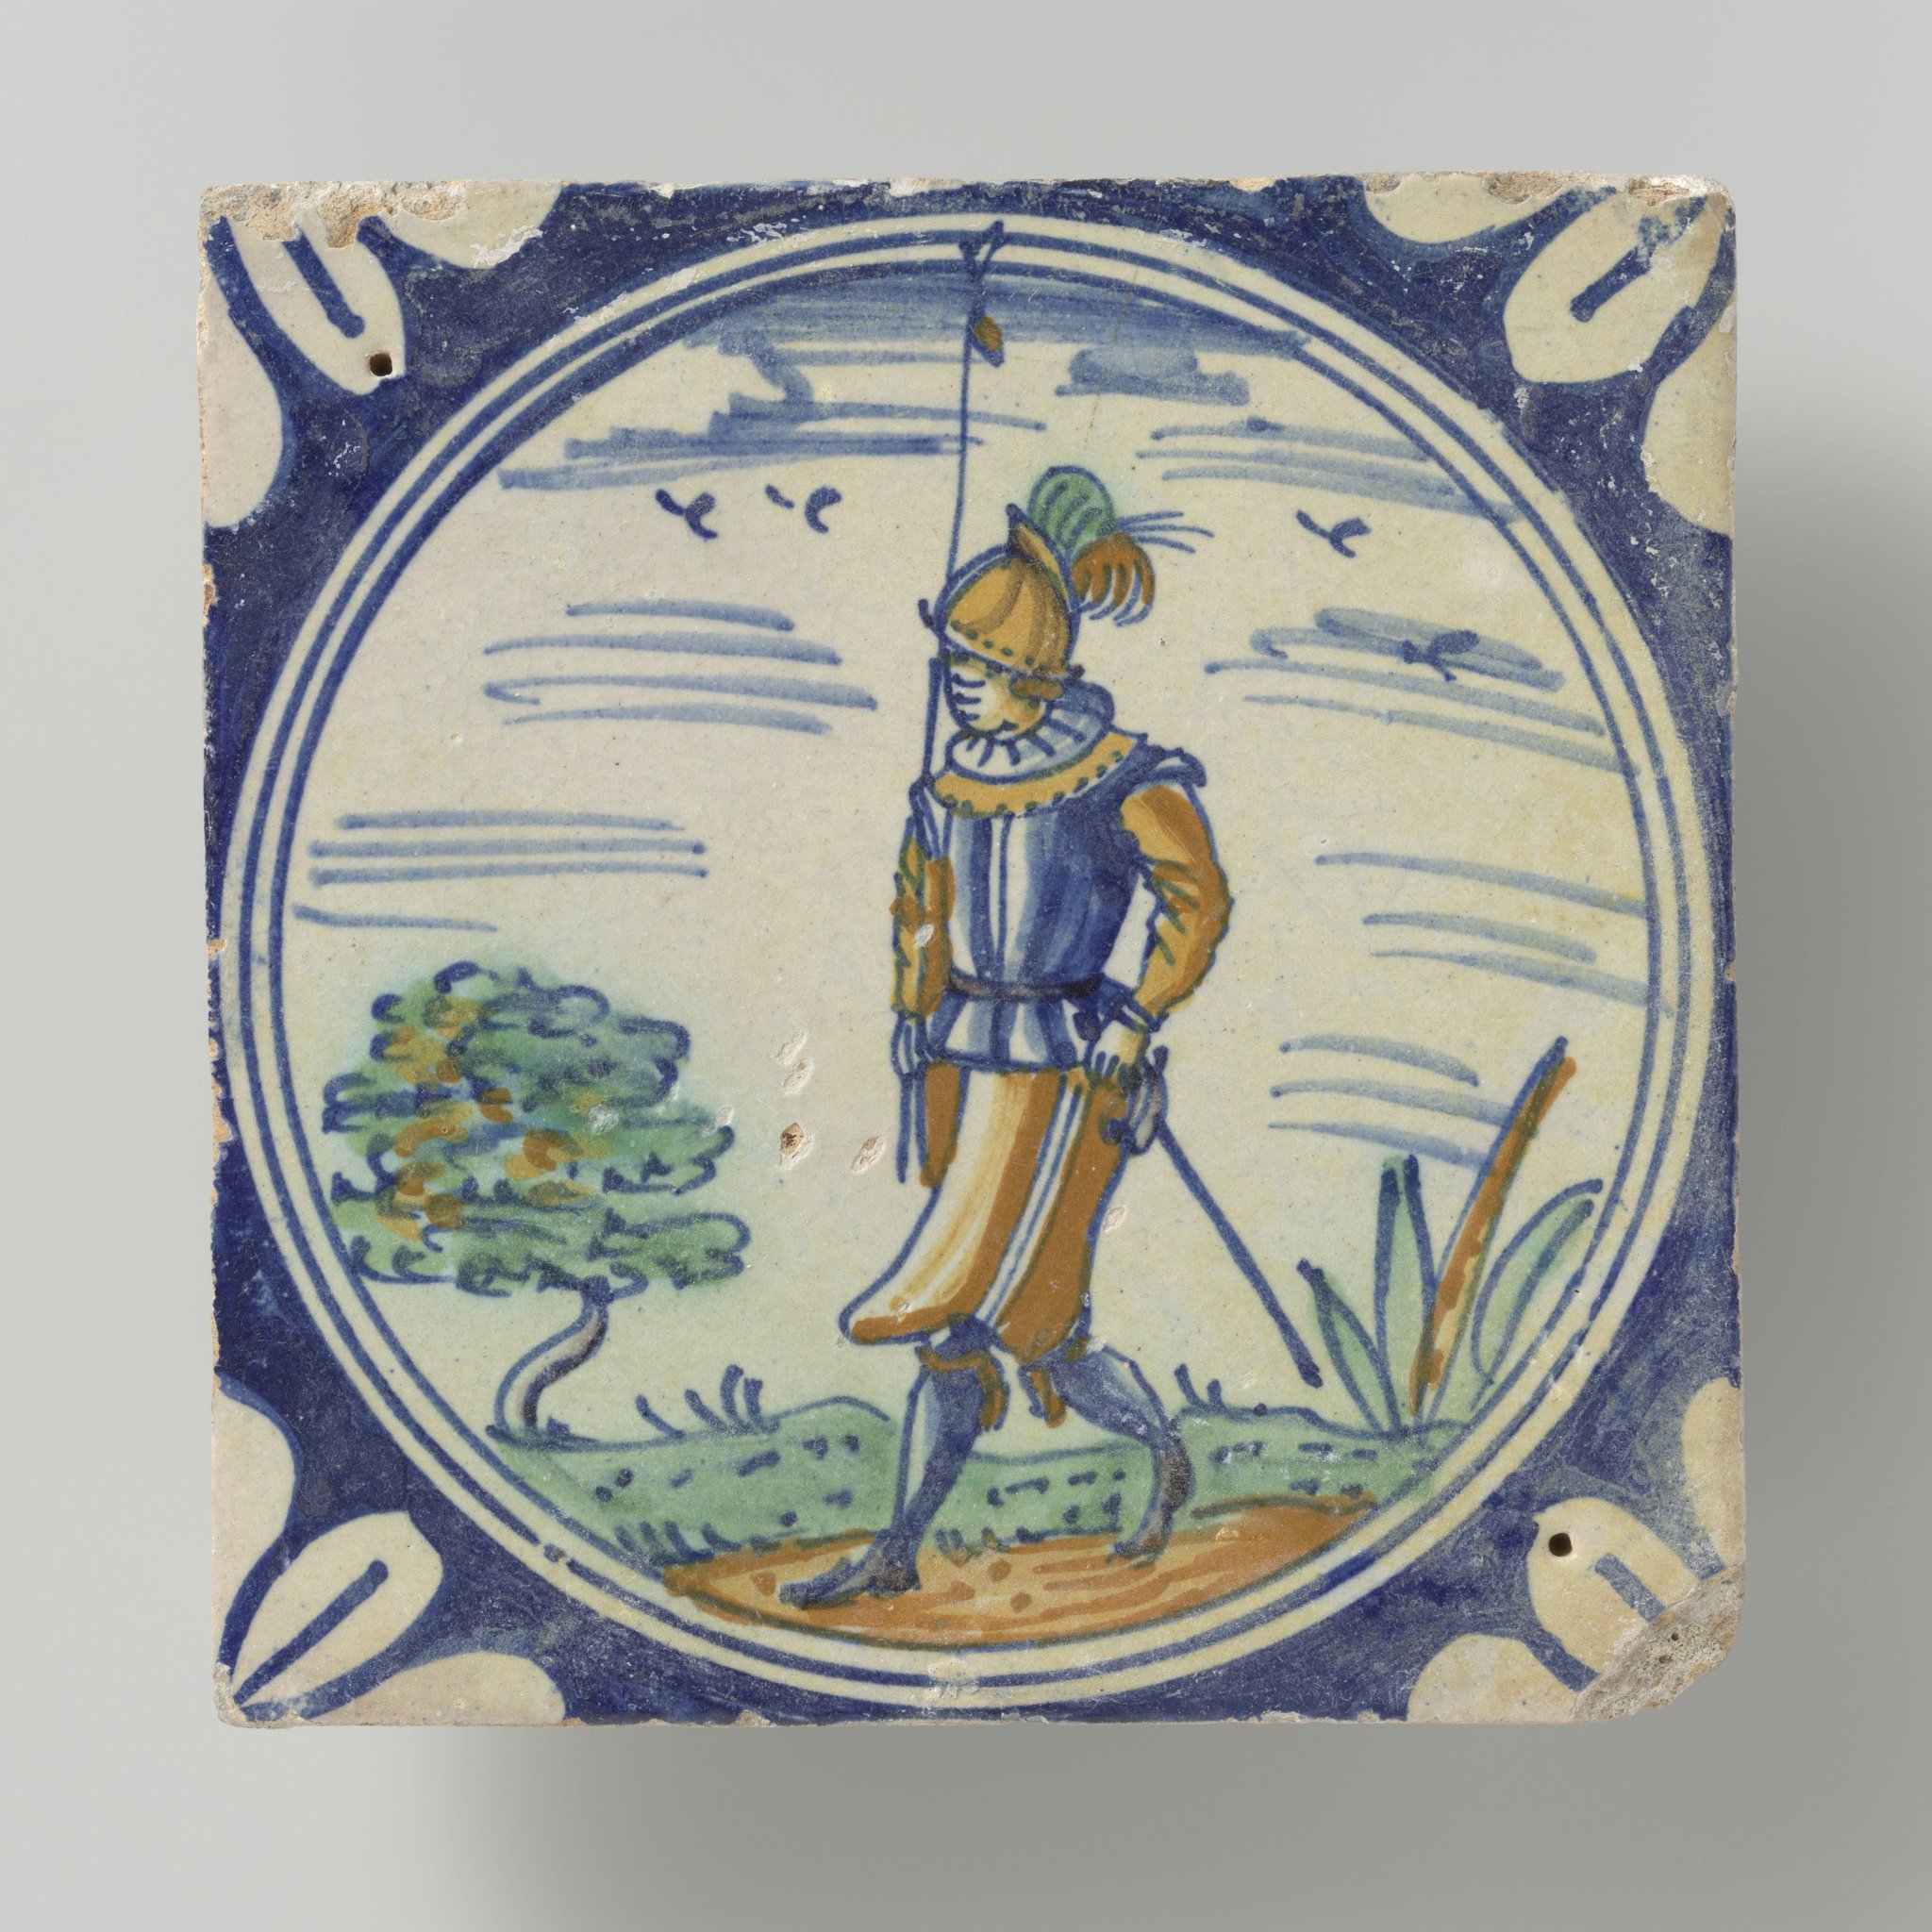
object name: tile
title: Tegel, veelkleurig beschilderd met een soldaat of een vaandeldrager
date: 1625-1700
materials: earthenware, glaze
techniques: maiolica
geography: netherlands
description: Tegel, veelkleurig beschilderd met een soldaat of een vaandeldrager.